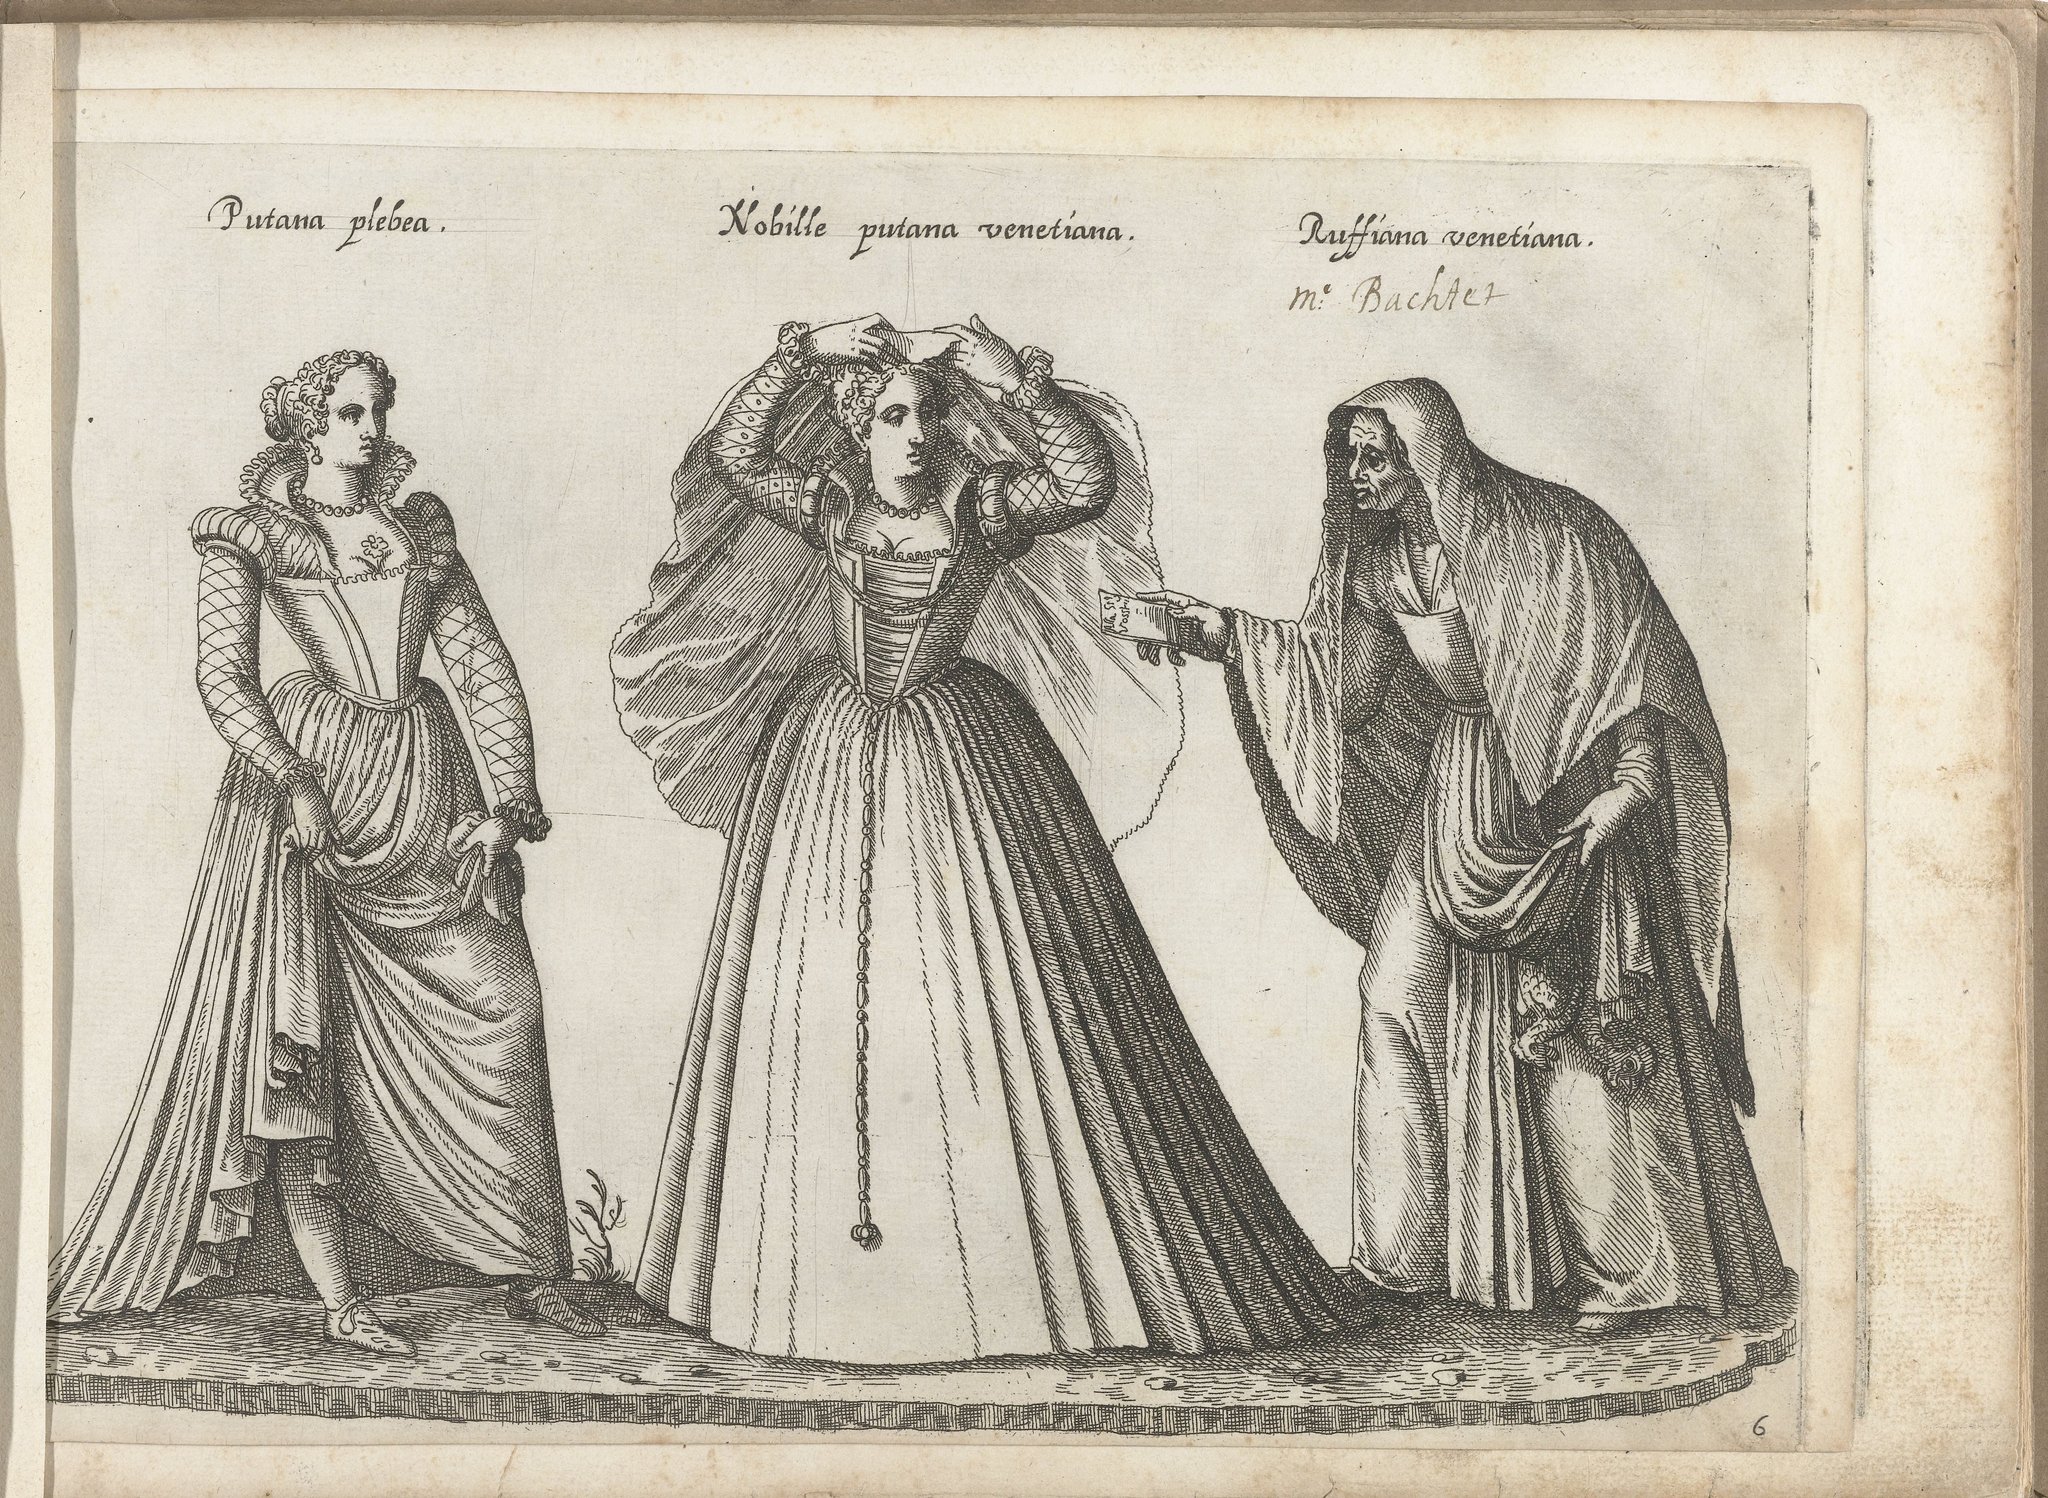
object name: costume print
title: Twee prostituées en een oude koppelaarster, gekleed volgens de Venetiaanse mode ca. 1580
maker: bartolomeo grassi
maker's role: publisher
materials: paper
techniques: engraving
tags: belt, girdle, waistband, courtesan, hetaera, whore, prostitute, madam (brothel scene)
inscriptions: number: ‘5’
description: Prent nr. 6 uit album 'Dei veri ritratti degl'habiti di tvtte le parti del mondo intagliati in rame per opra di Bartolomeo Grassi', 1585.